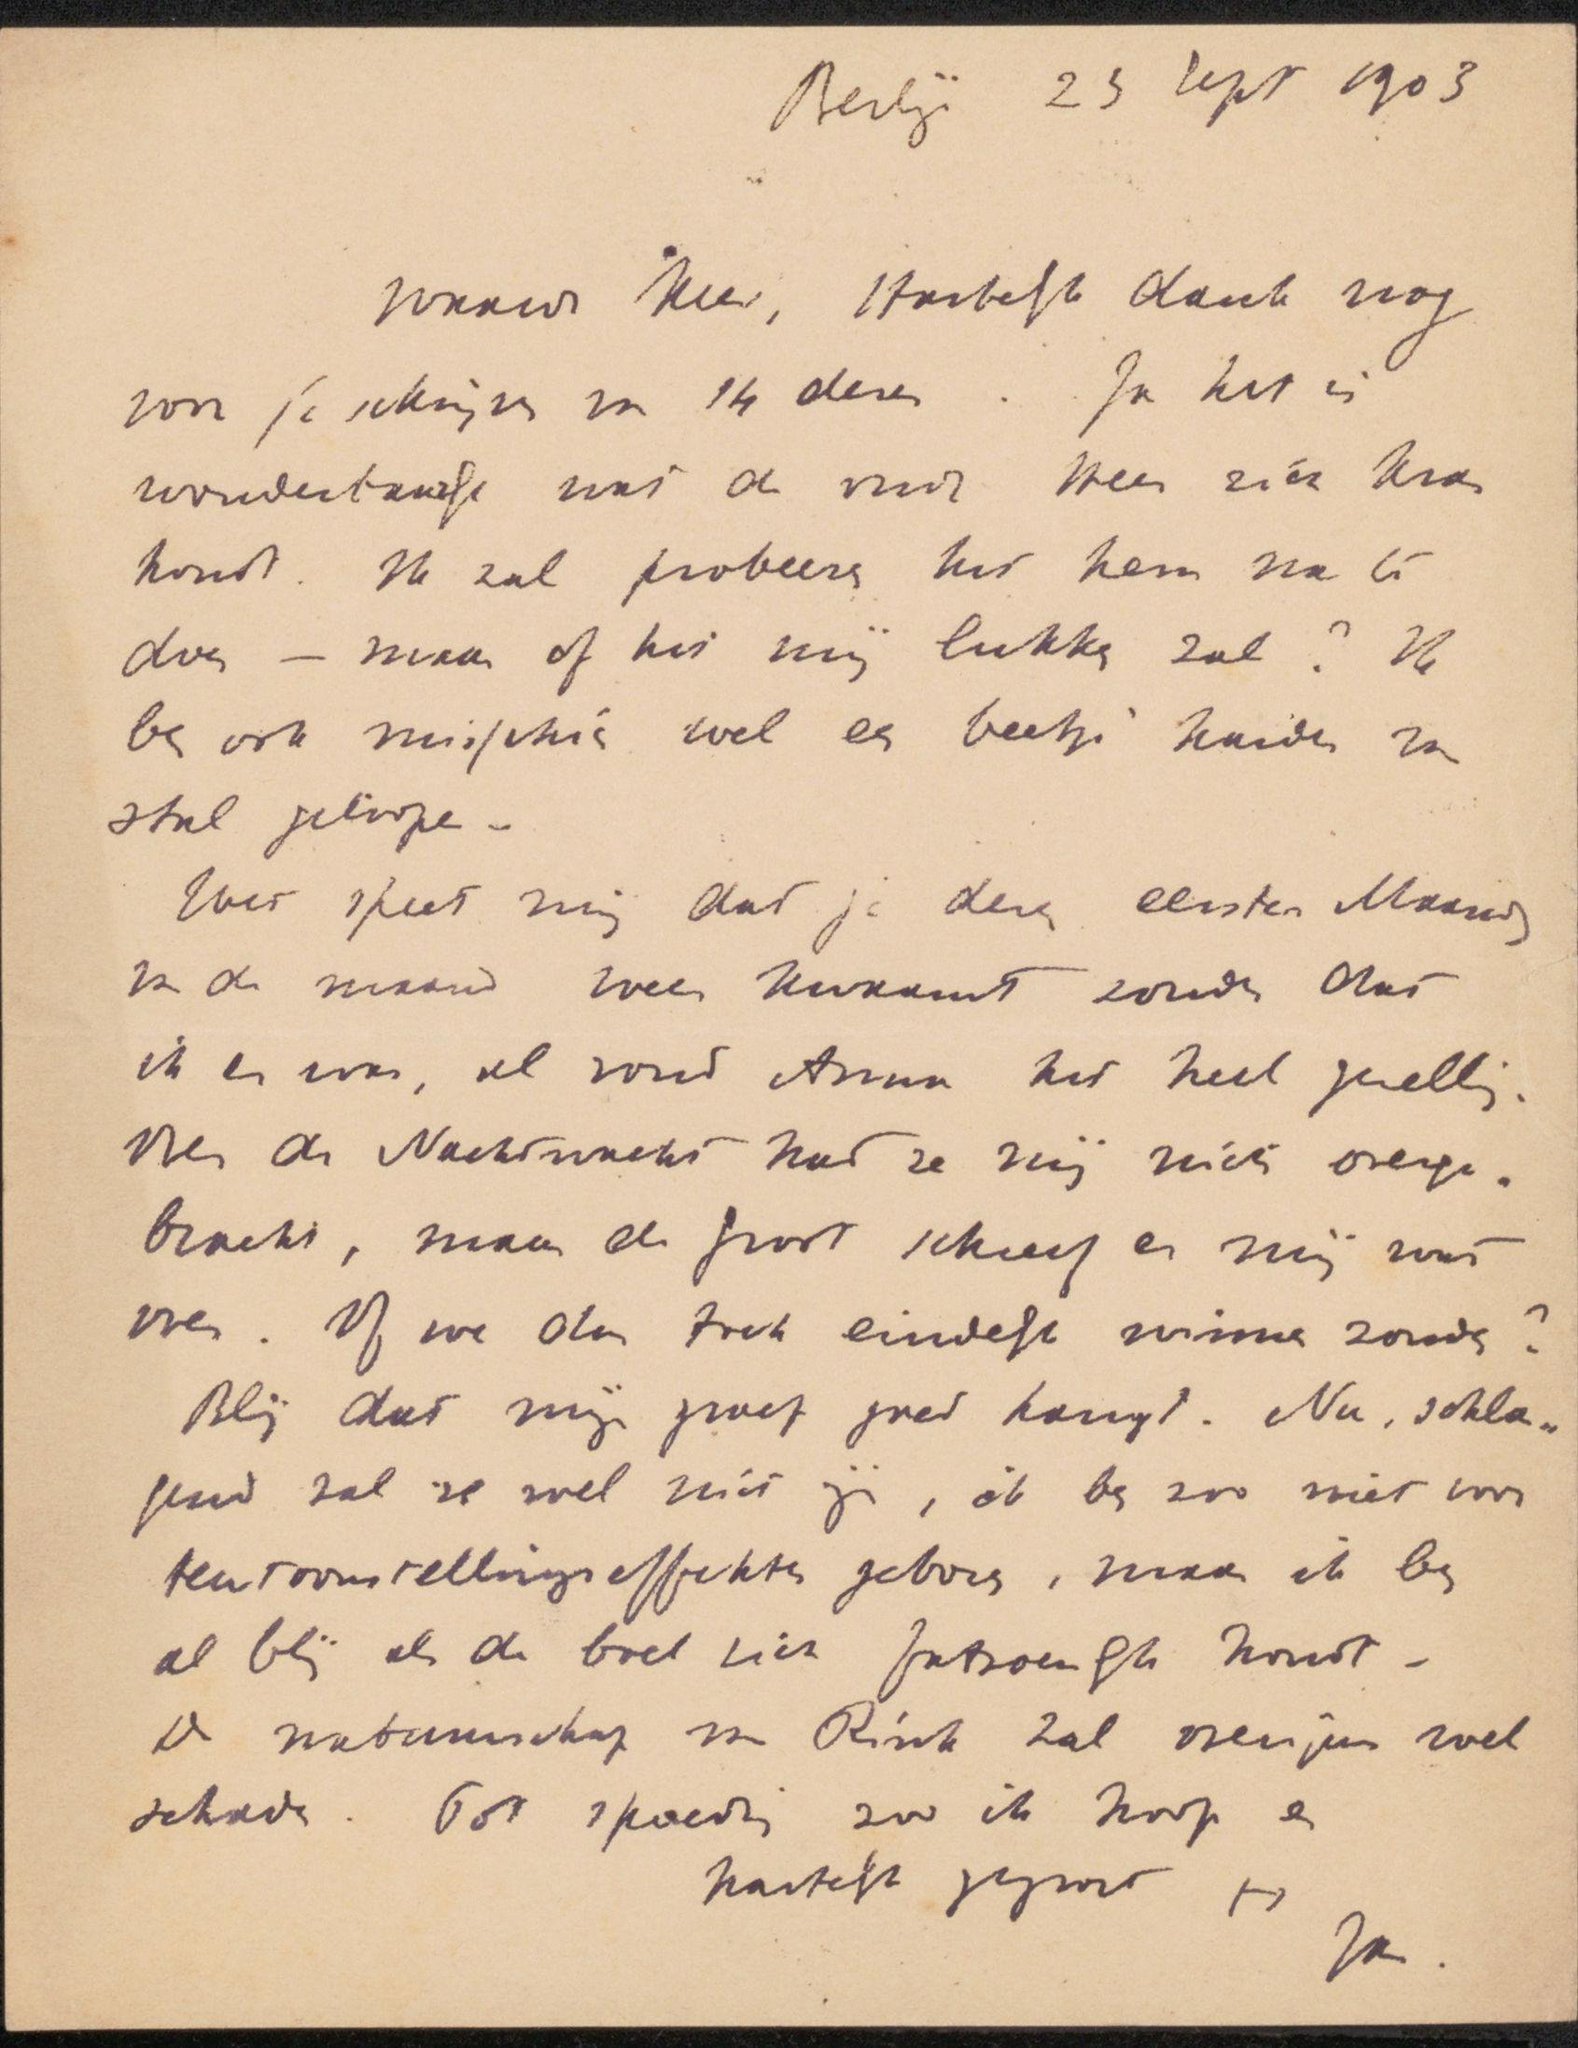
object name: letter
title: Brief aan Cornelis Gerardus 't Hooft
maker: jan veth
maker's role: designer, draughtsman, painter, print maker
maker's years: 1864-1925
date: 1903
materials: ink, paper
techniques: pen, writing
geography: berlin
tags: amsterdam, painter, print maker, draughtsman, rembrandt van rijn, paul rink, cornelis hofstede de groot, cornelis gerardus 't hooft, painting (including book-illumination, miniature-painting)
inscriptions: collector's mark: ‘RPK’